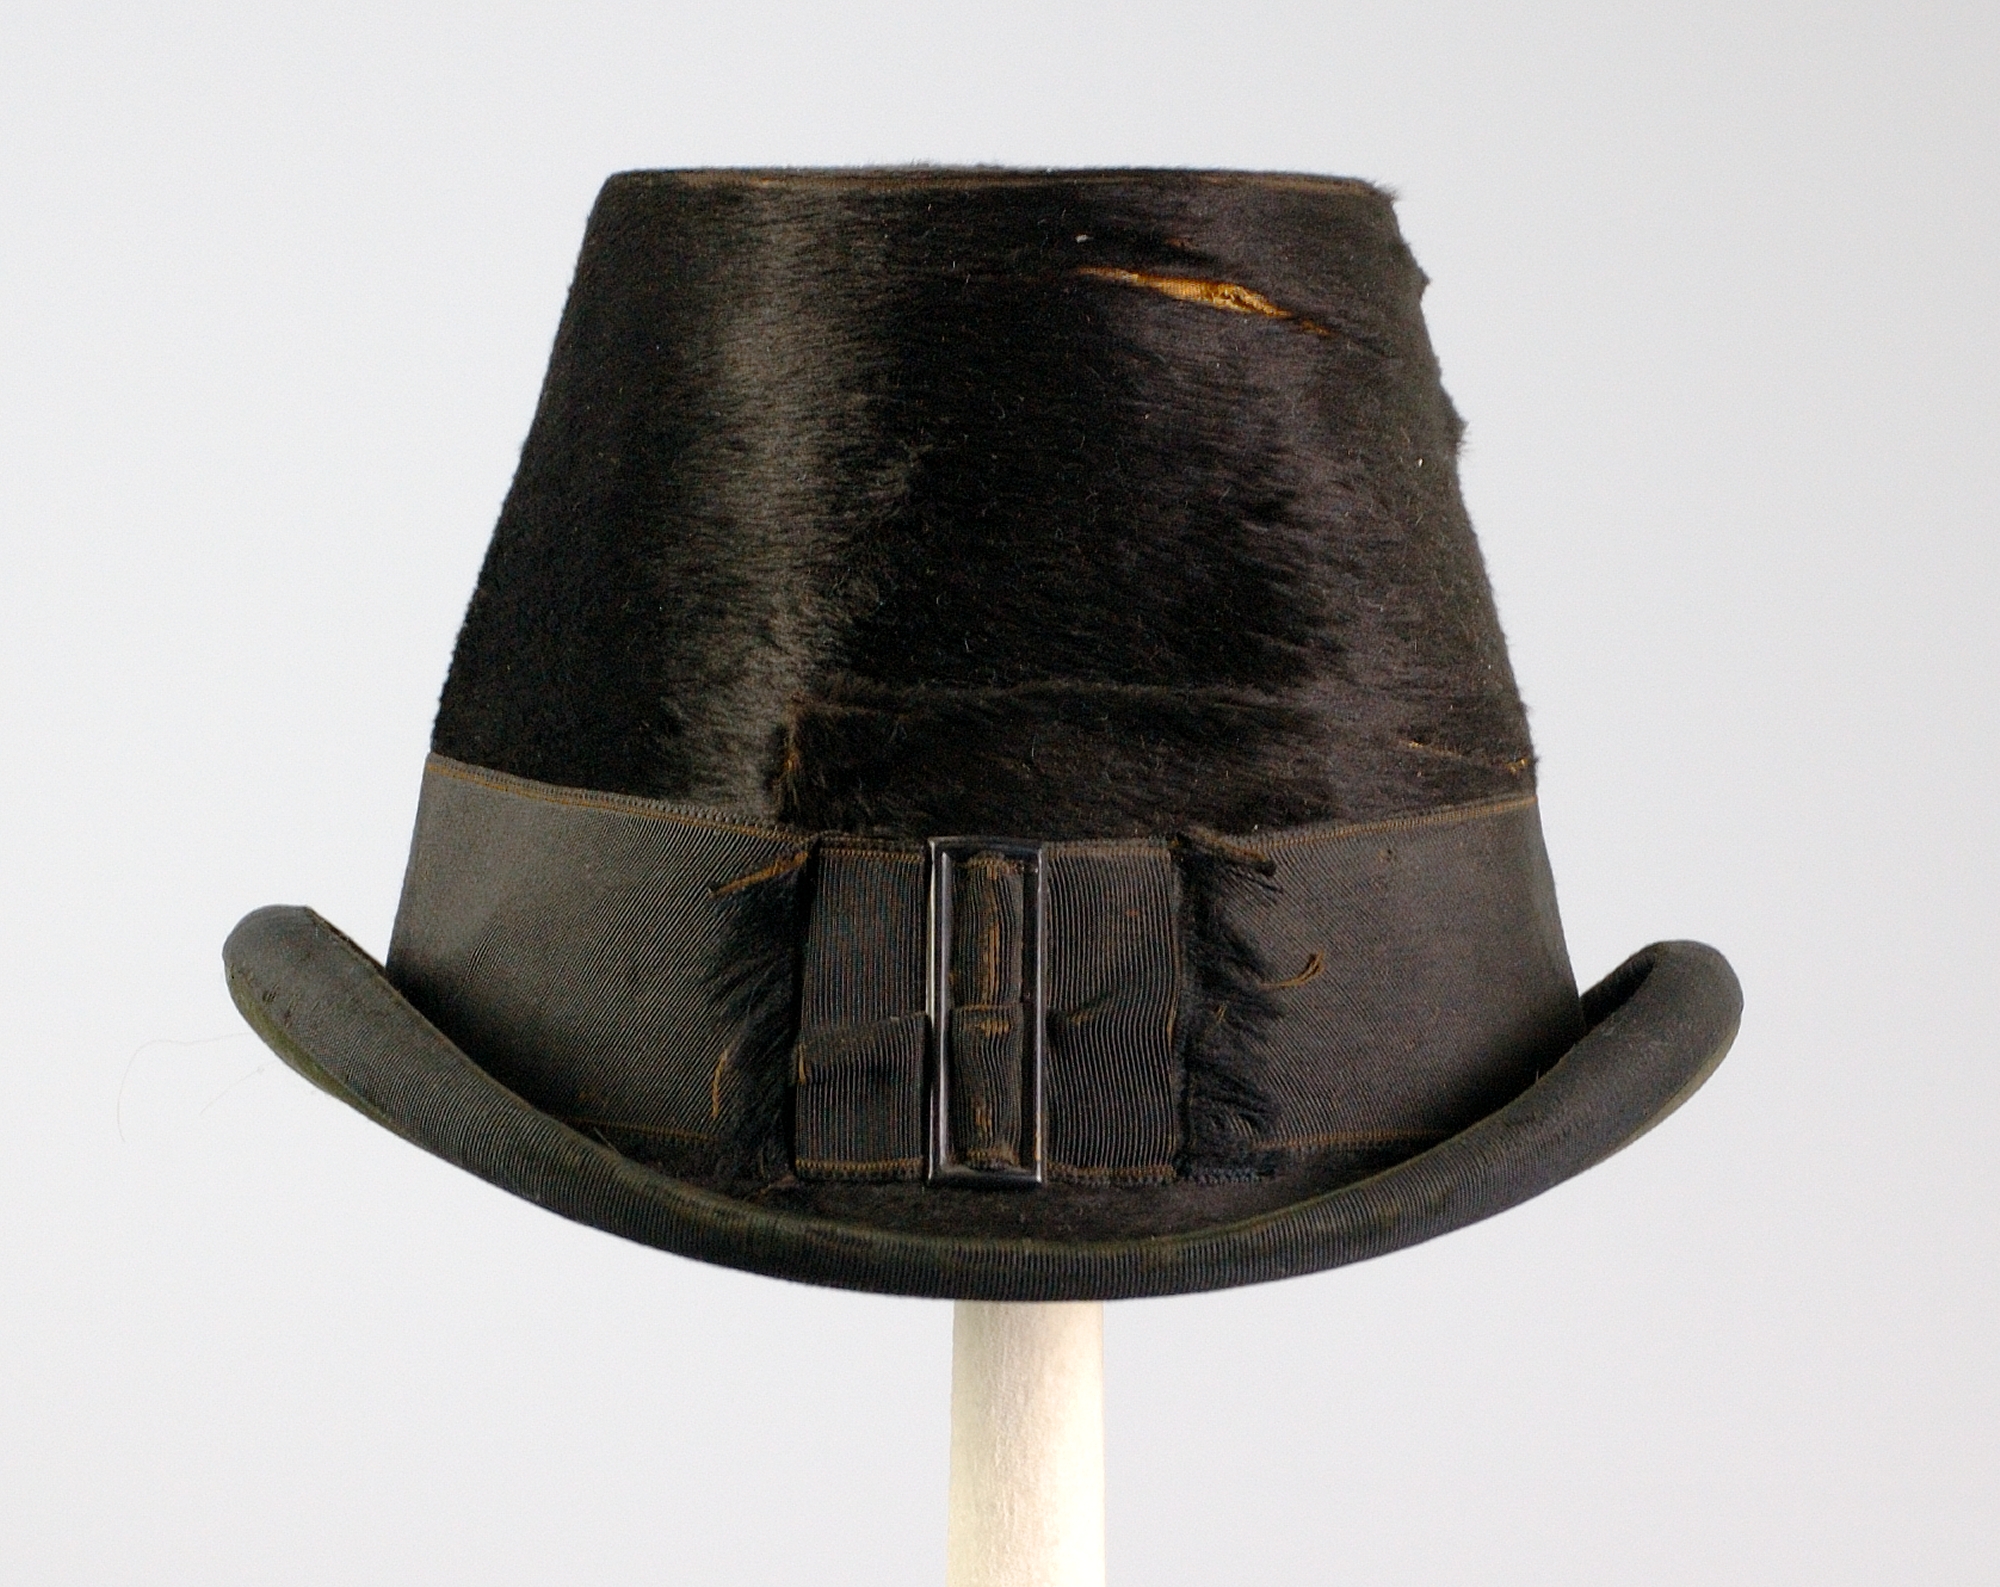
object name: hat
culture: american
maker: jordan marsh & company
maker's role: retailer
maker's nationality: american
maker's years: 1841-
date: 1890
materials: fur, metal, silk